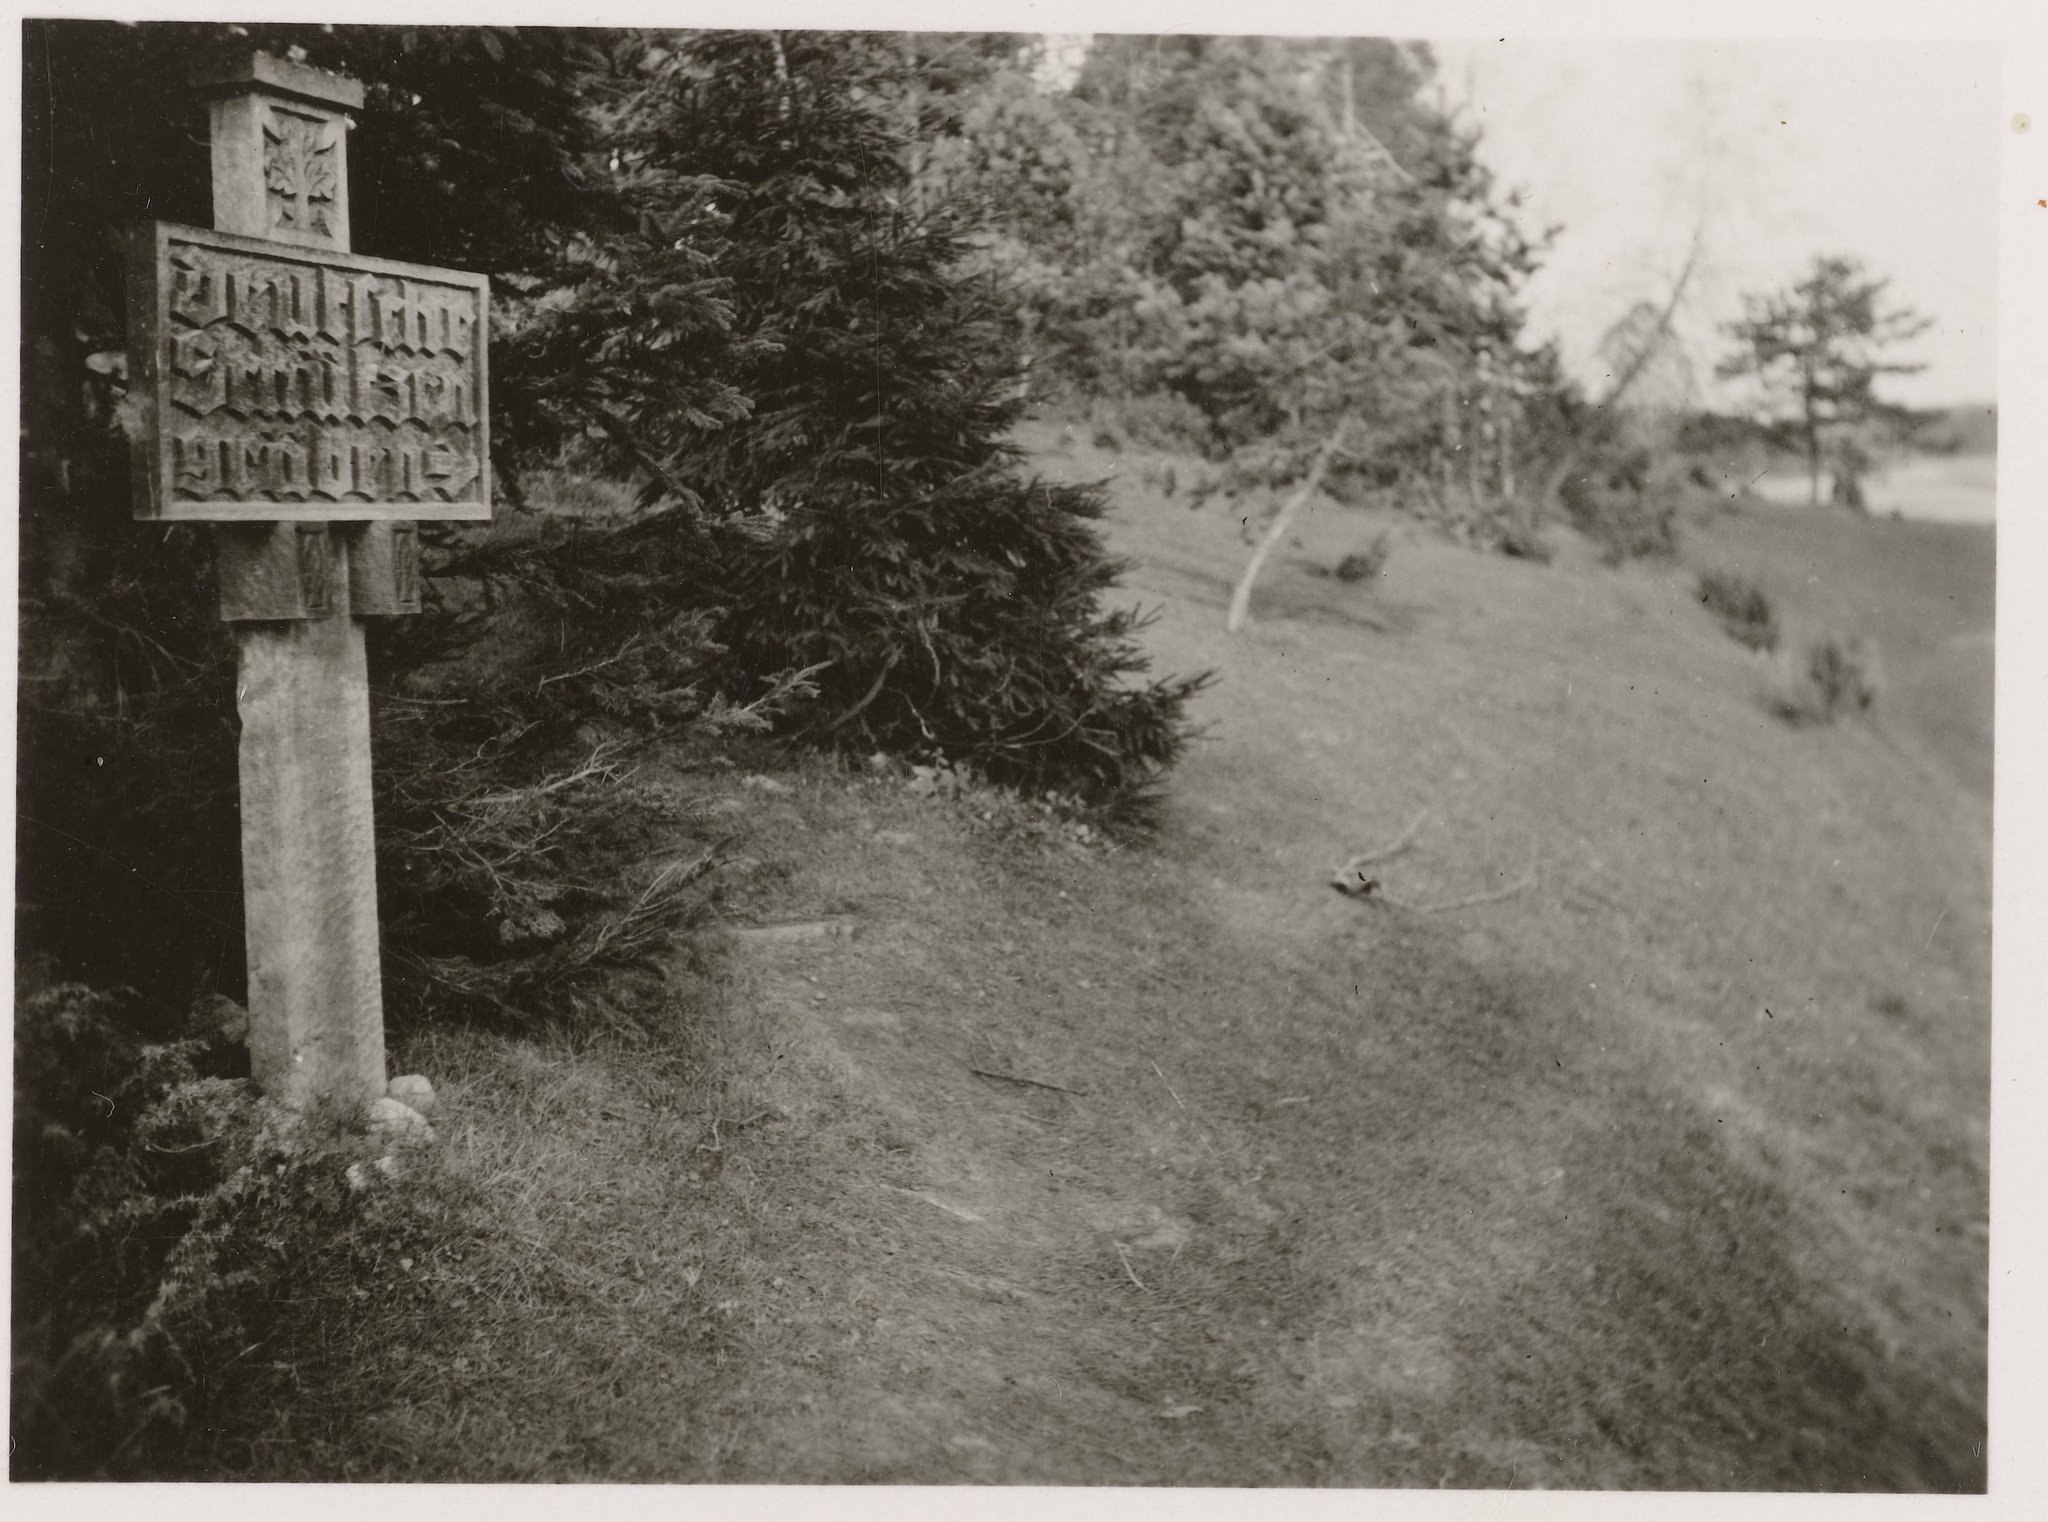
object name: photograph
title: Een monument langs de weg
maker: Anonymous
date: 1940-1945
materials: photographic support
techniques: gelatin silver print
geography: germany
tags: netherlands, germany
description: Richtingaanwijzer langs de weg. Opschrift: Deutsche schütsengraben. Foto behorend bij album 'Kriegserinnerungen'.